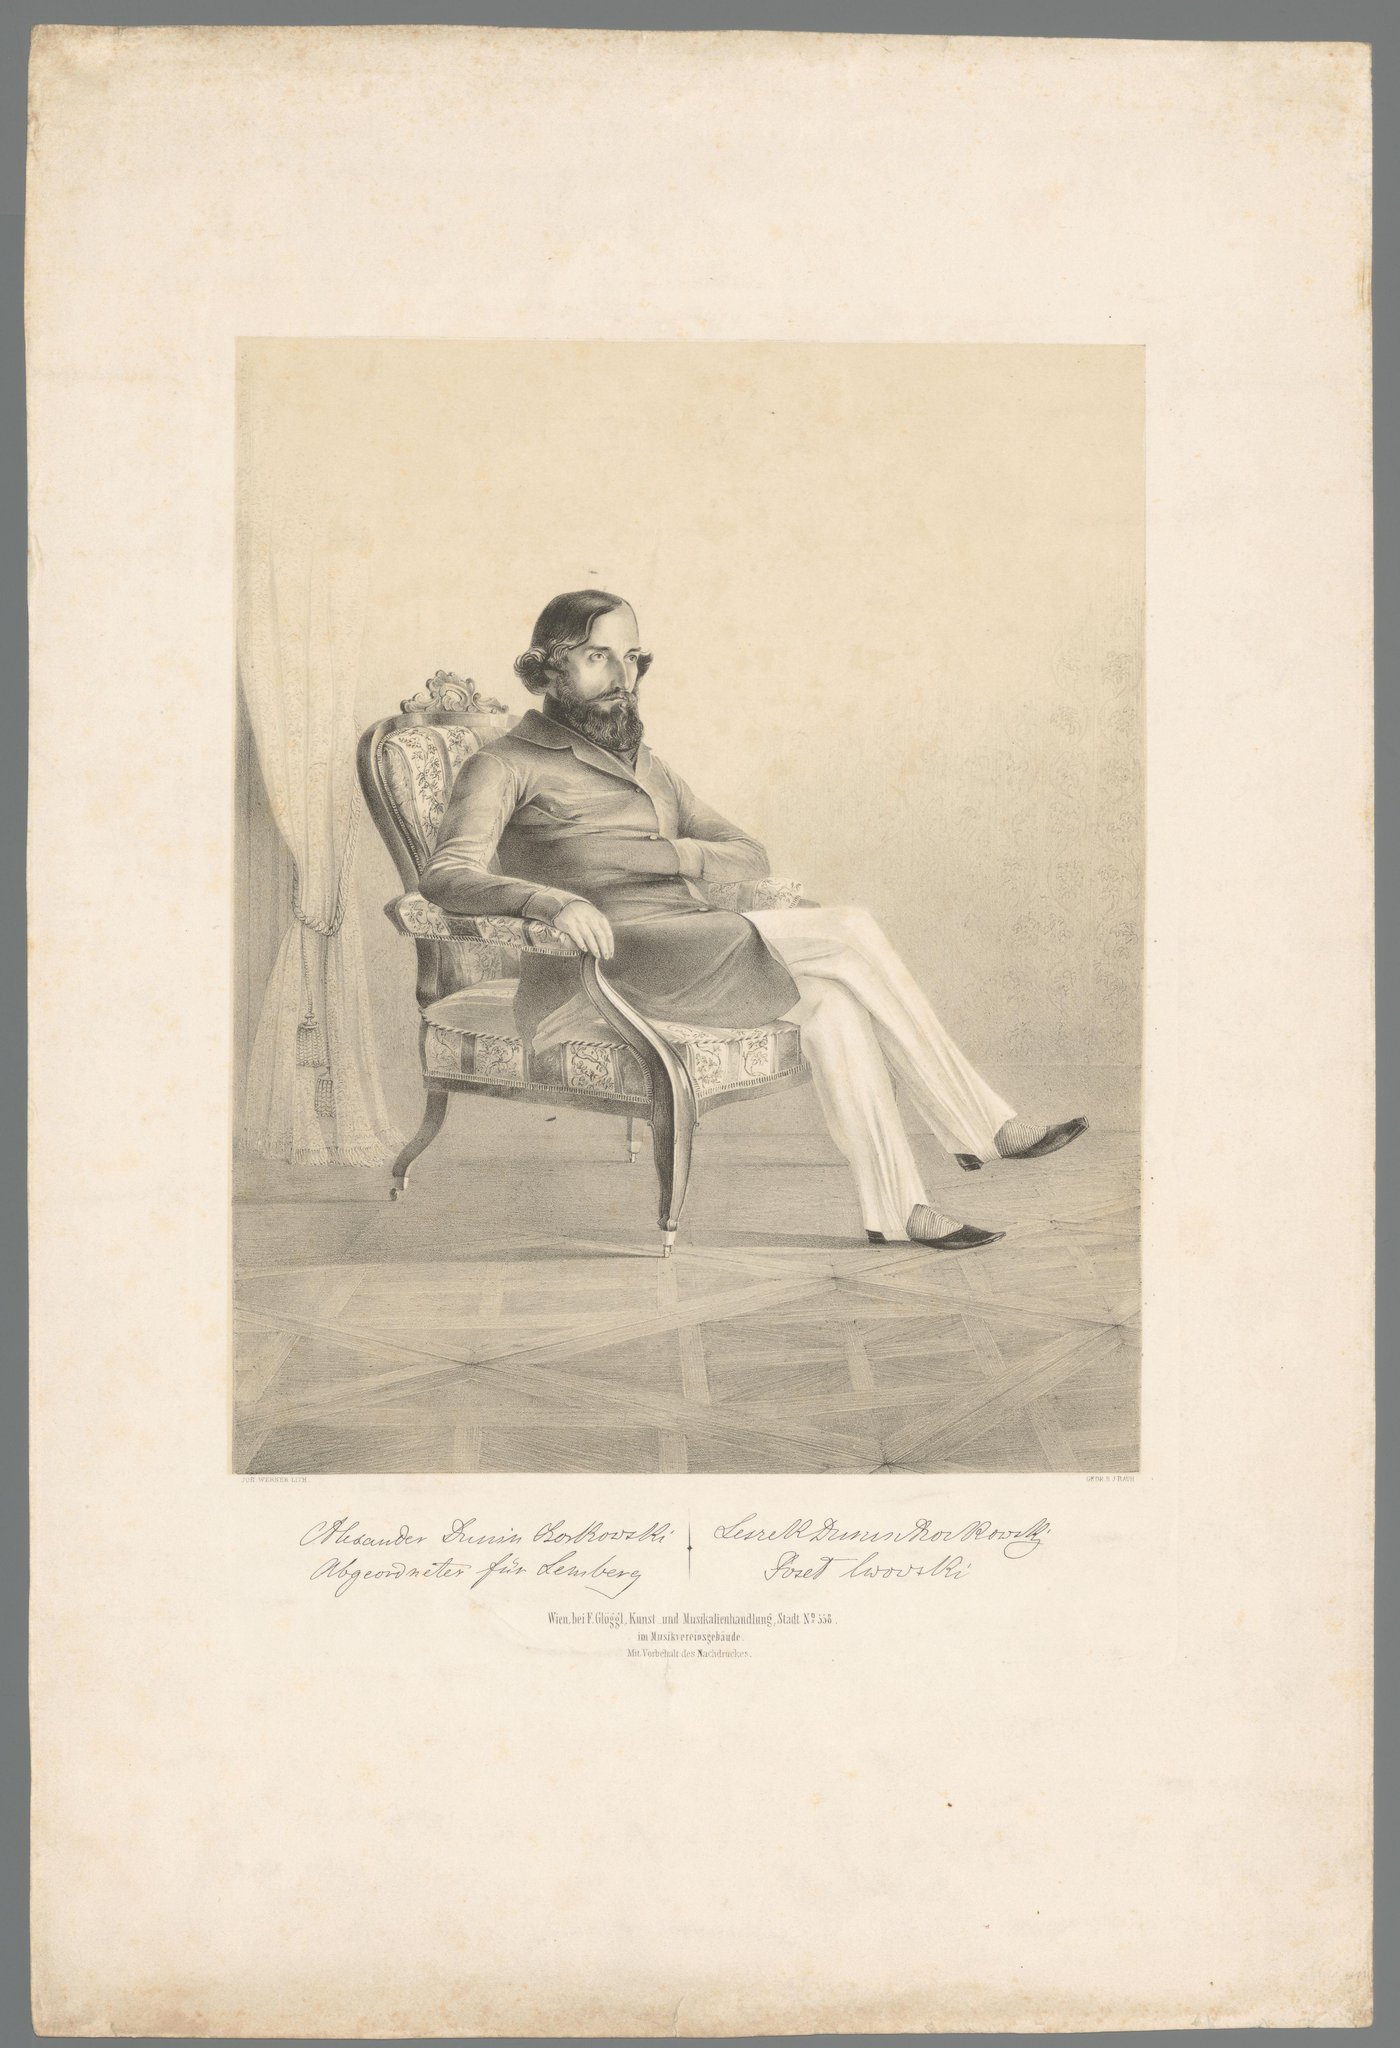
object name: print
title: Portret van een onbekende man, mogelijk Aleksander Koskowski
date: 1820-1880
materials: paper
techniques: tone lithography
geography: vienna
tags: curtains, armchair, seat, adult man, historical persons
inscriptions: collector's mark: Lugt 2228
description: Onderschrift in facsimile in twee talen.